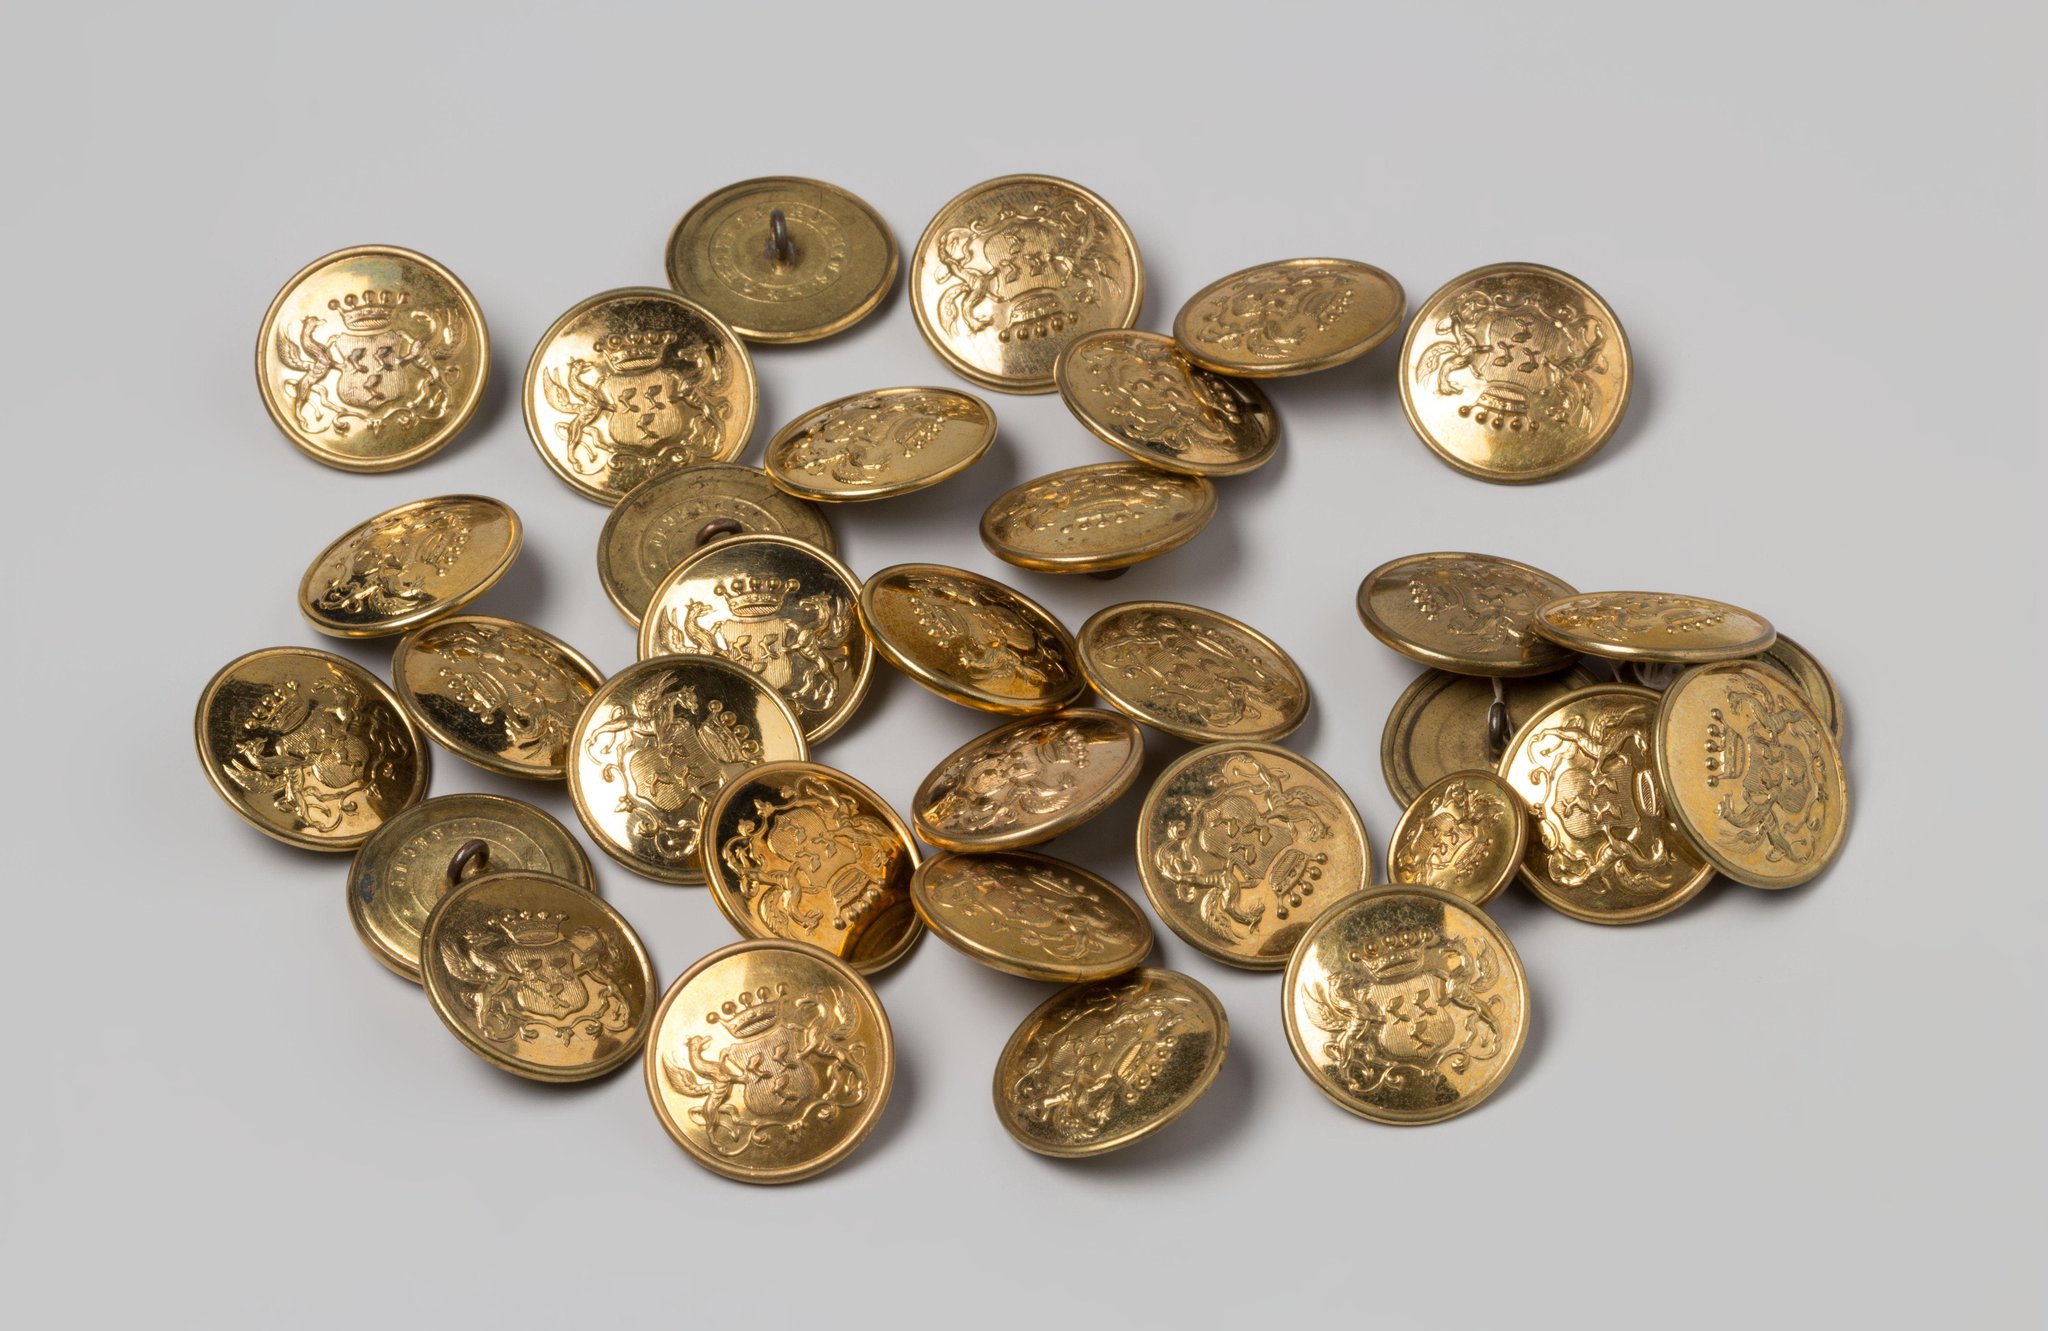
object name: button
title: Livreiknopen van koper met het familiewapen Van Styrum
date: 1800-1849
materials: copper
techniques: forging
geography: utrecht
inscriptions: company name: ‘'H. de Heus & Z.' en 'Utrecht'’, coat of arms, company name: ‘'Mansvelt & Zn' en 's Hage'’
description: Livreiknopen van koper met het familiewapen Van Styrum; 32 grote en 1 kleine. Gemerkt, maar niet allemaal.